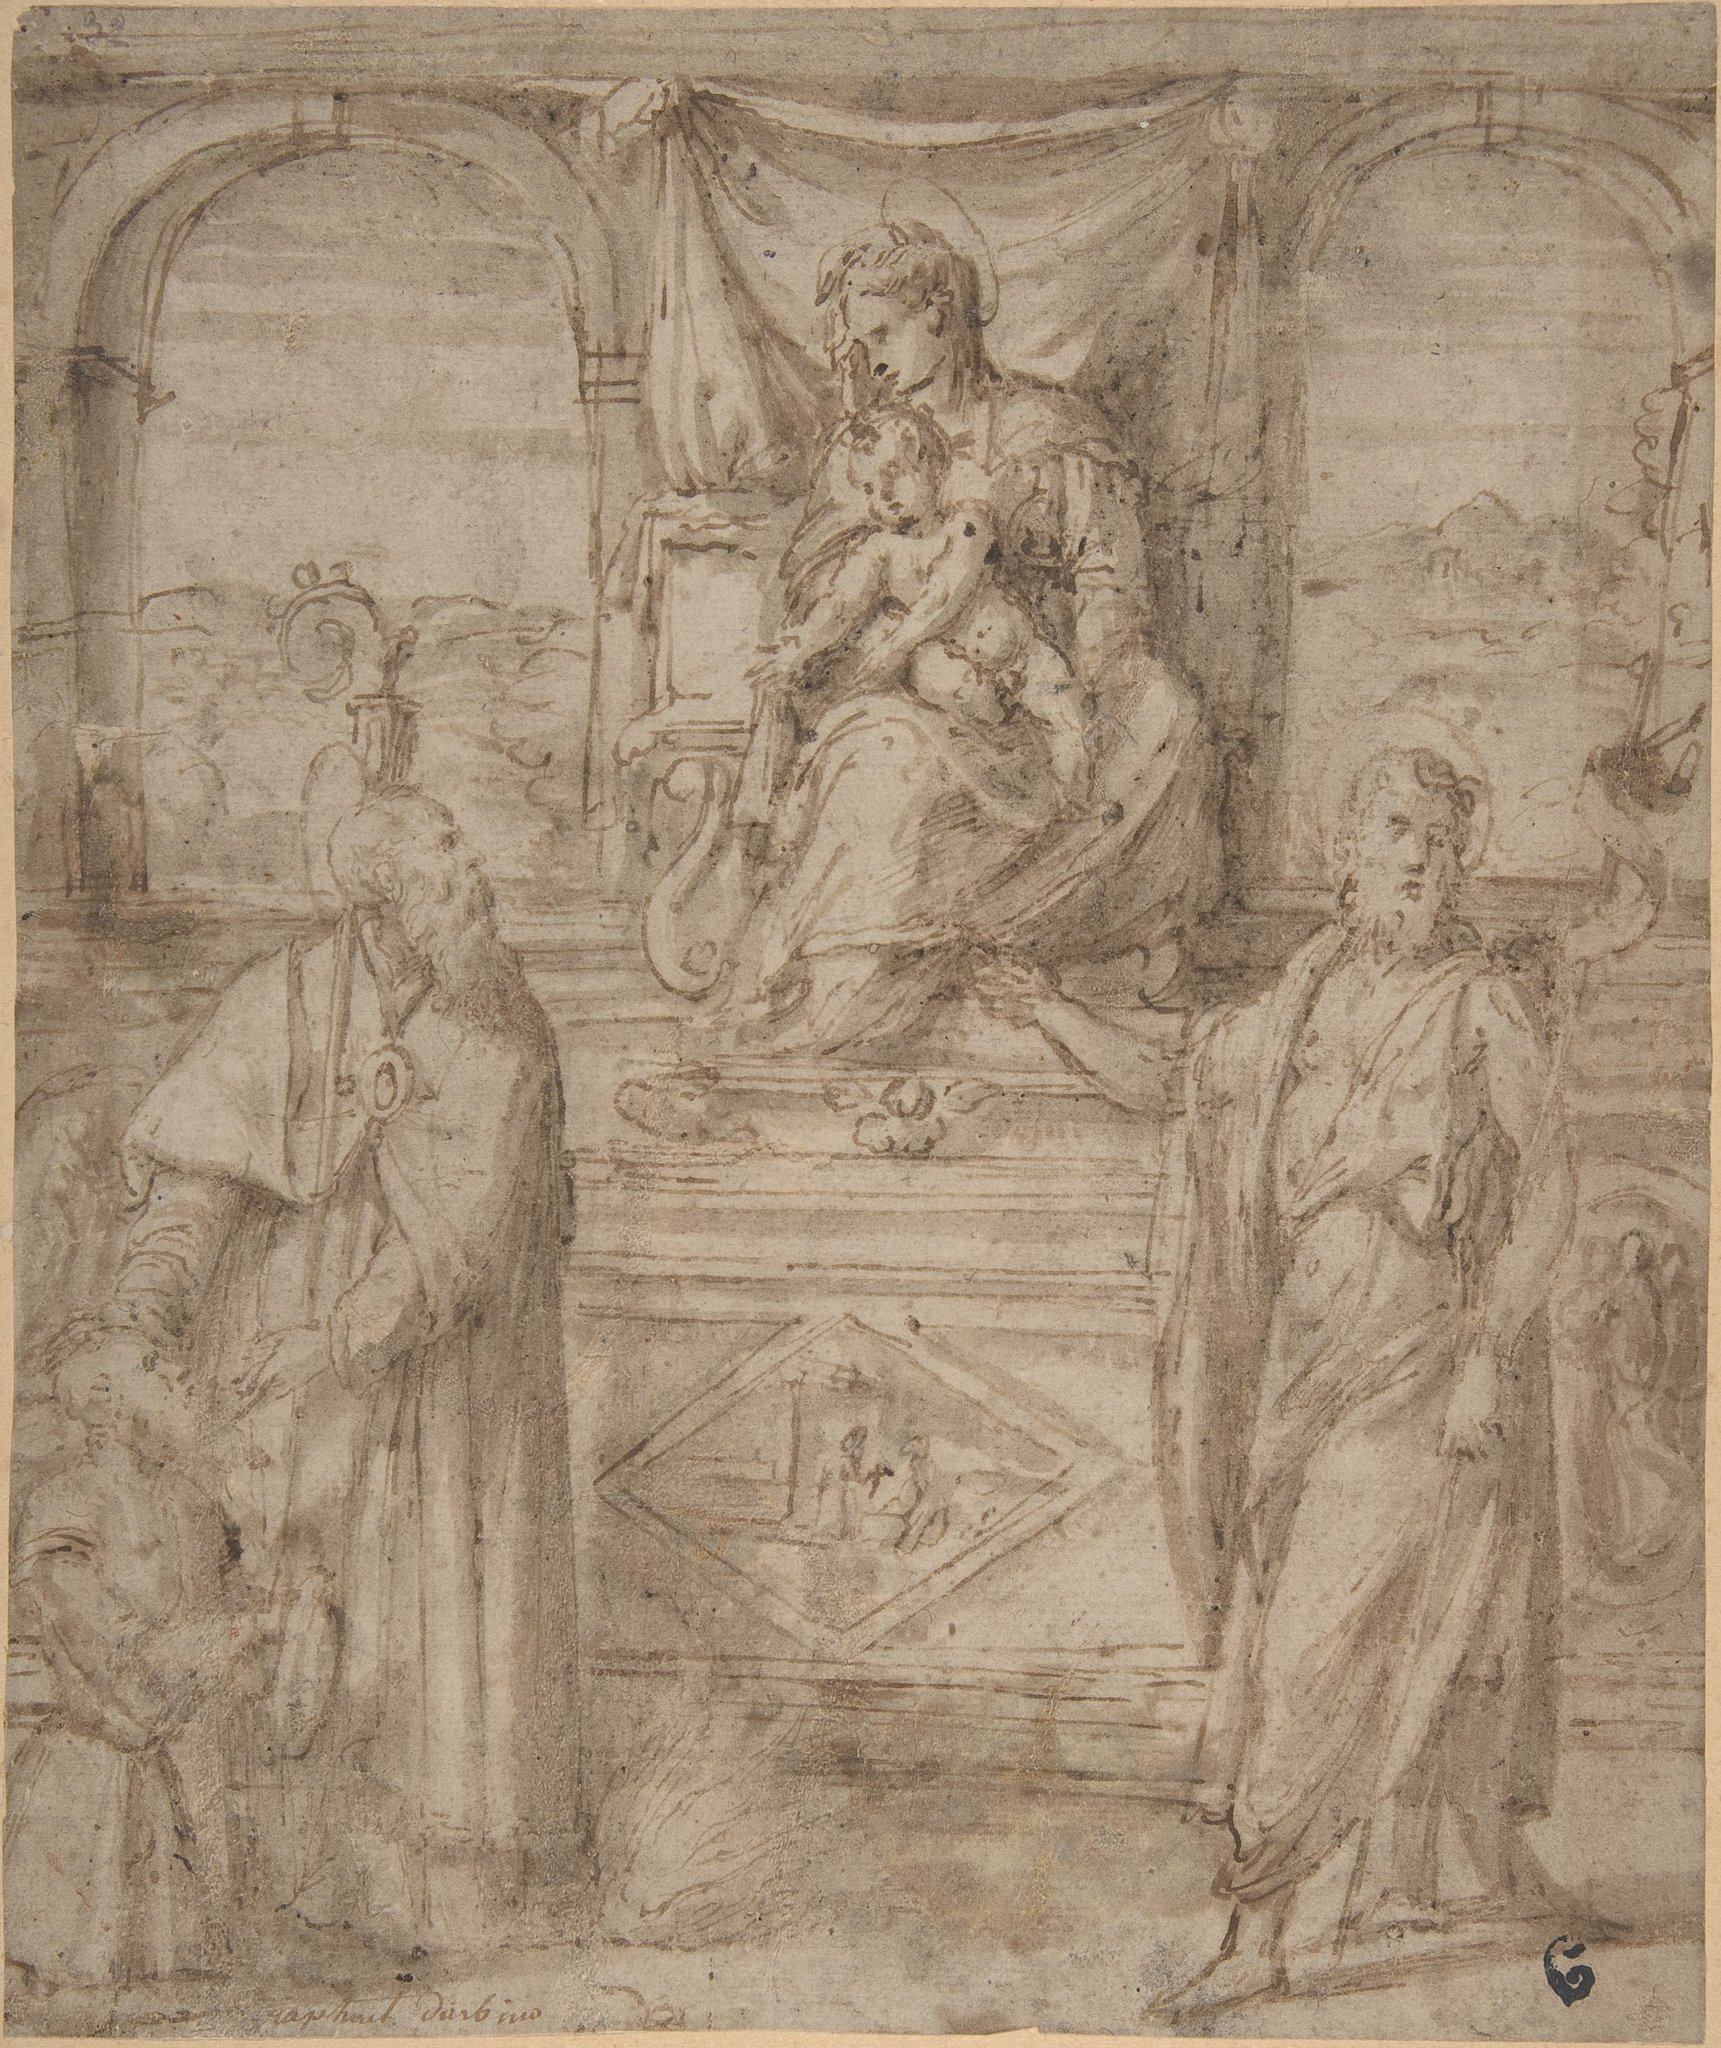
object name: drawing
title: Madonna and Child Enthroned with Saint Basil the Great and Saint John the Baptist and Donor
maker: niccolò dell' abate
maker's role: artist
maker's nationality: italian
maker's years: 1509-1571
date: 1540-1550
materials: board, ink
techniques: brush, pen, wash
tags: madonna and child,saint john the baptist